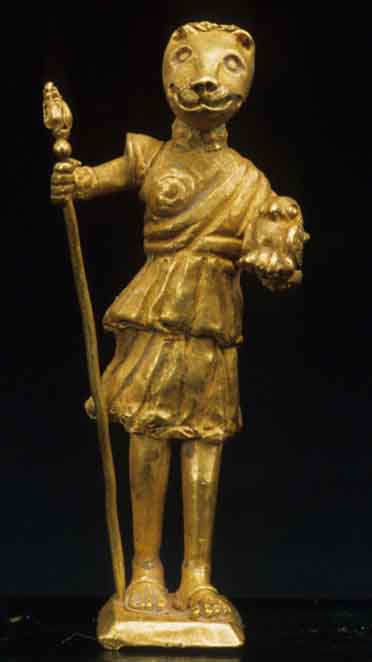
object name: statuette, anubis, defender of osiris dionysus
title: Anubis as Defender of Osiris / Dionysus (?)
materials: gold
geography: egypt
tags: falcons,anubis